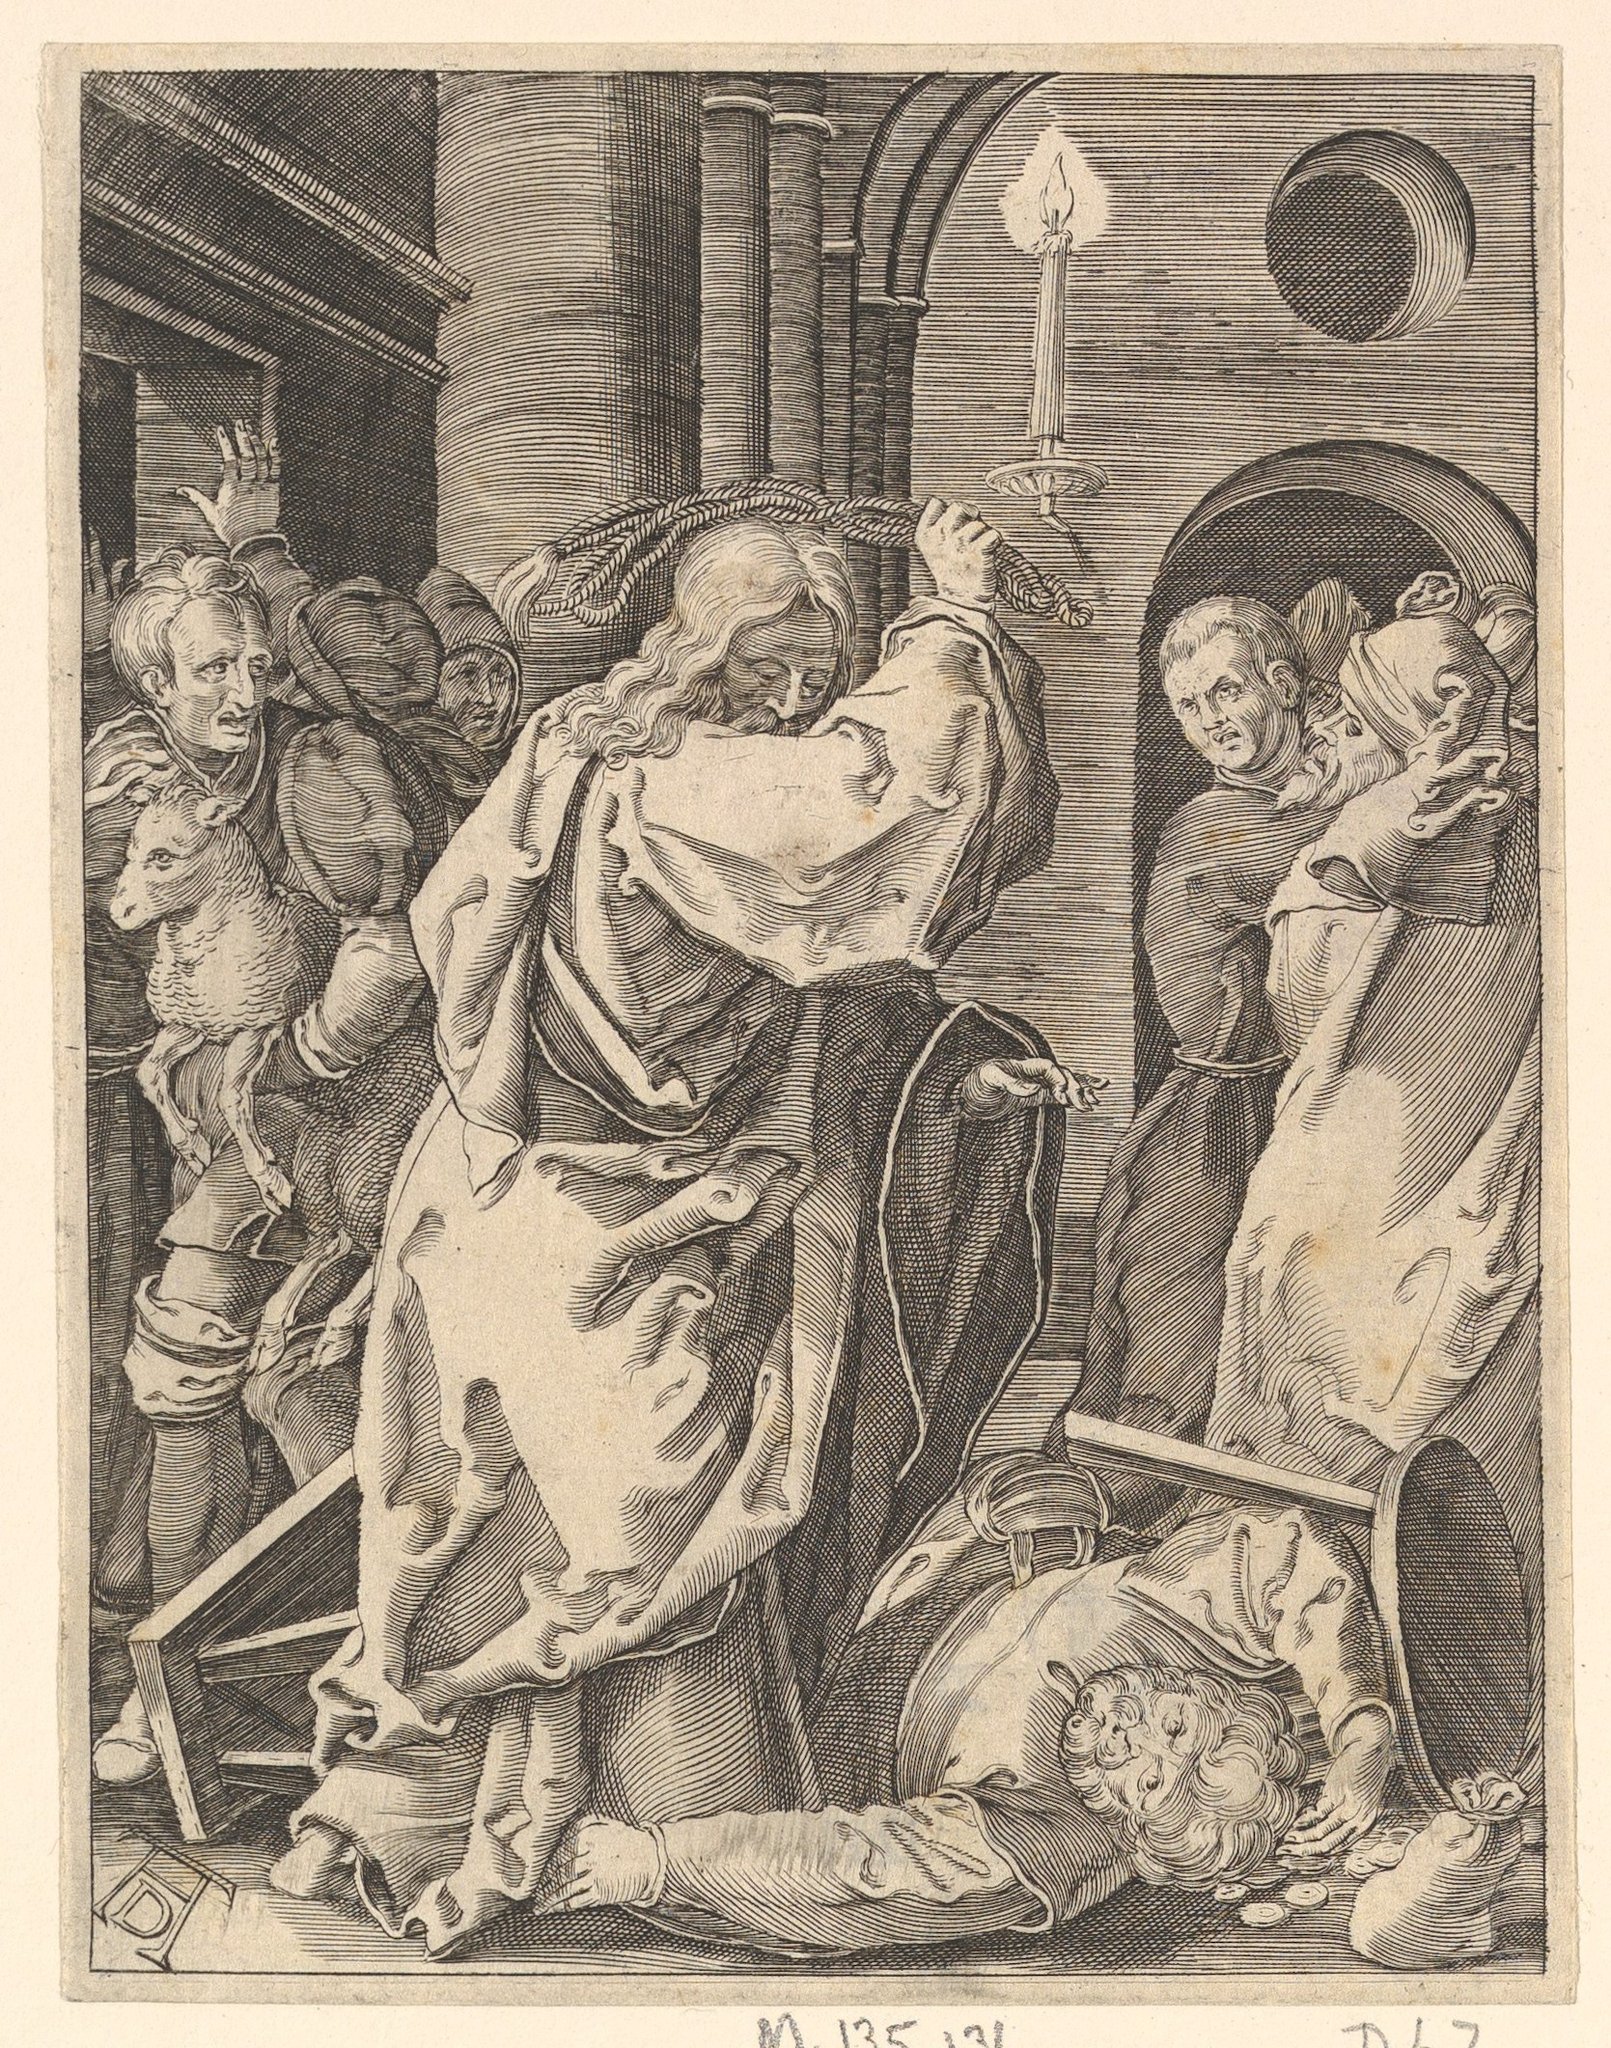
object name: print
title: Engraved copies of The Little Passion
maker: albrecht dürer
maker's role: artist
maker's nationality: german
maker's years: 1471-1528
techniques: engraving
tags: christ